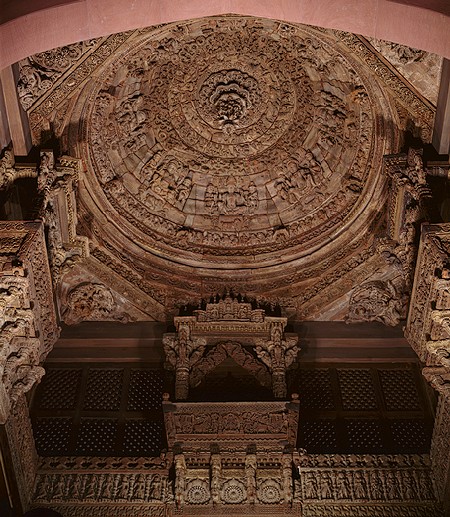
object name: architectural element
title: Ten Elements for East Window of an Architectural Ensemble from a Jain Meeting Hall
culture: indian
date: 1576-1600